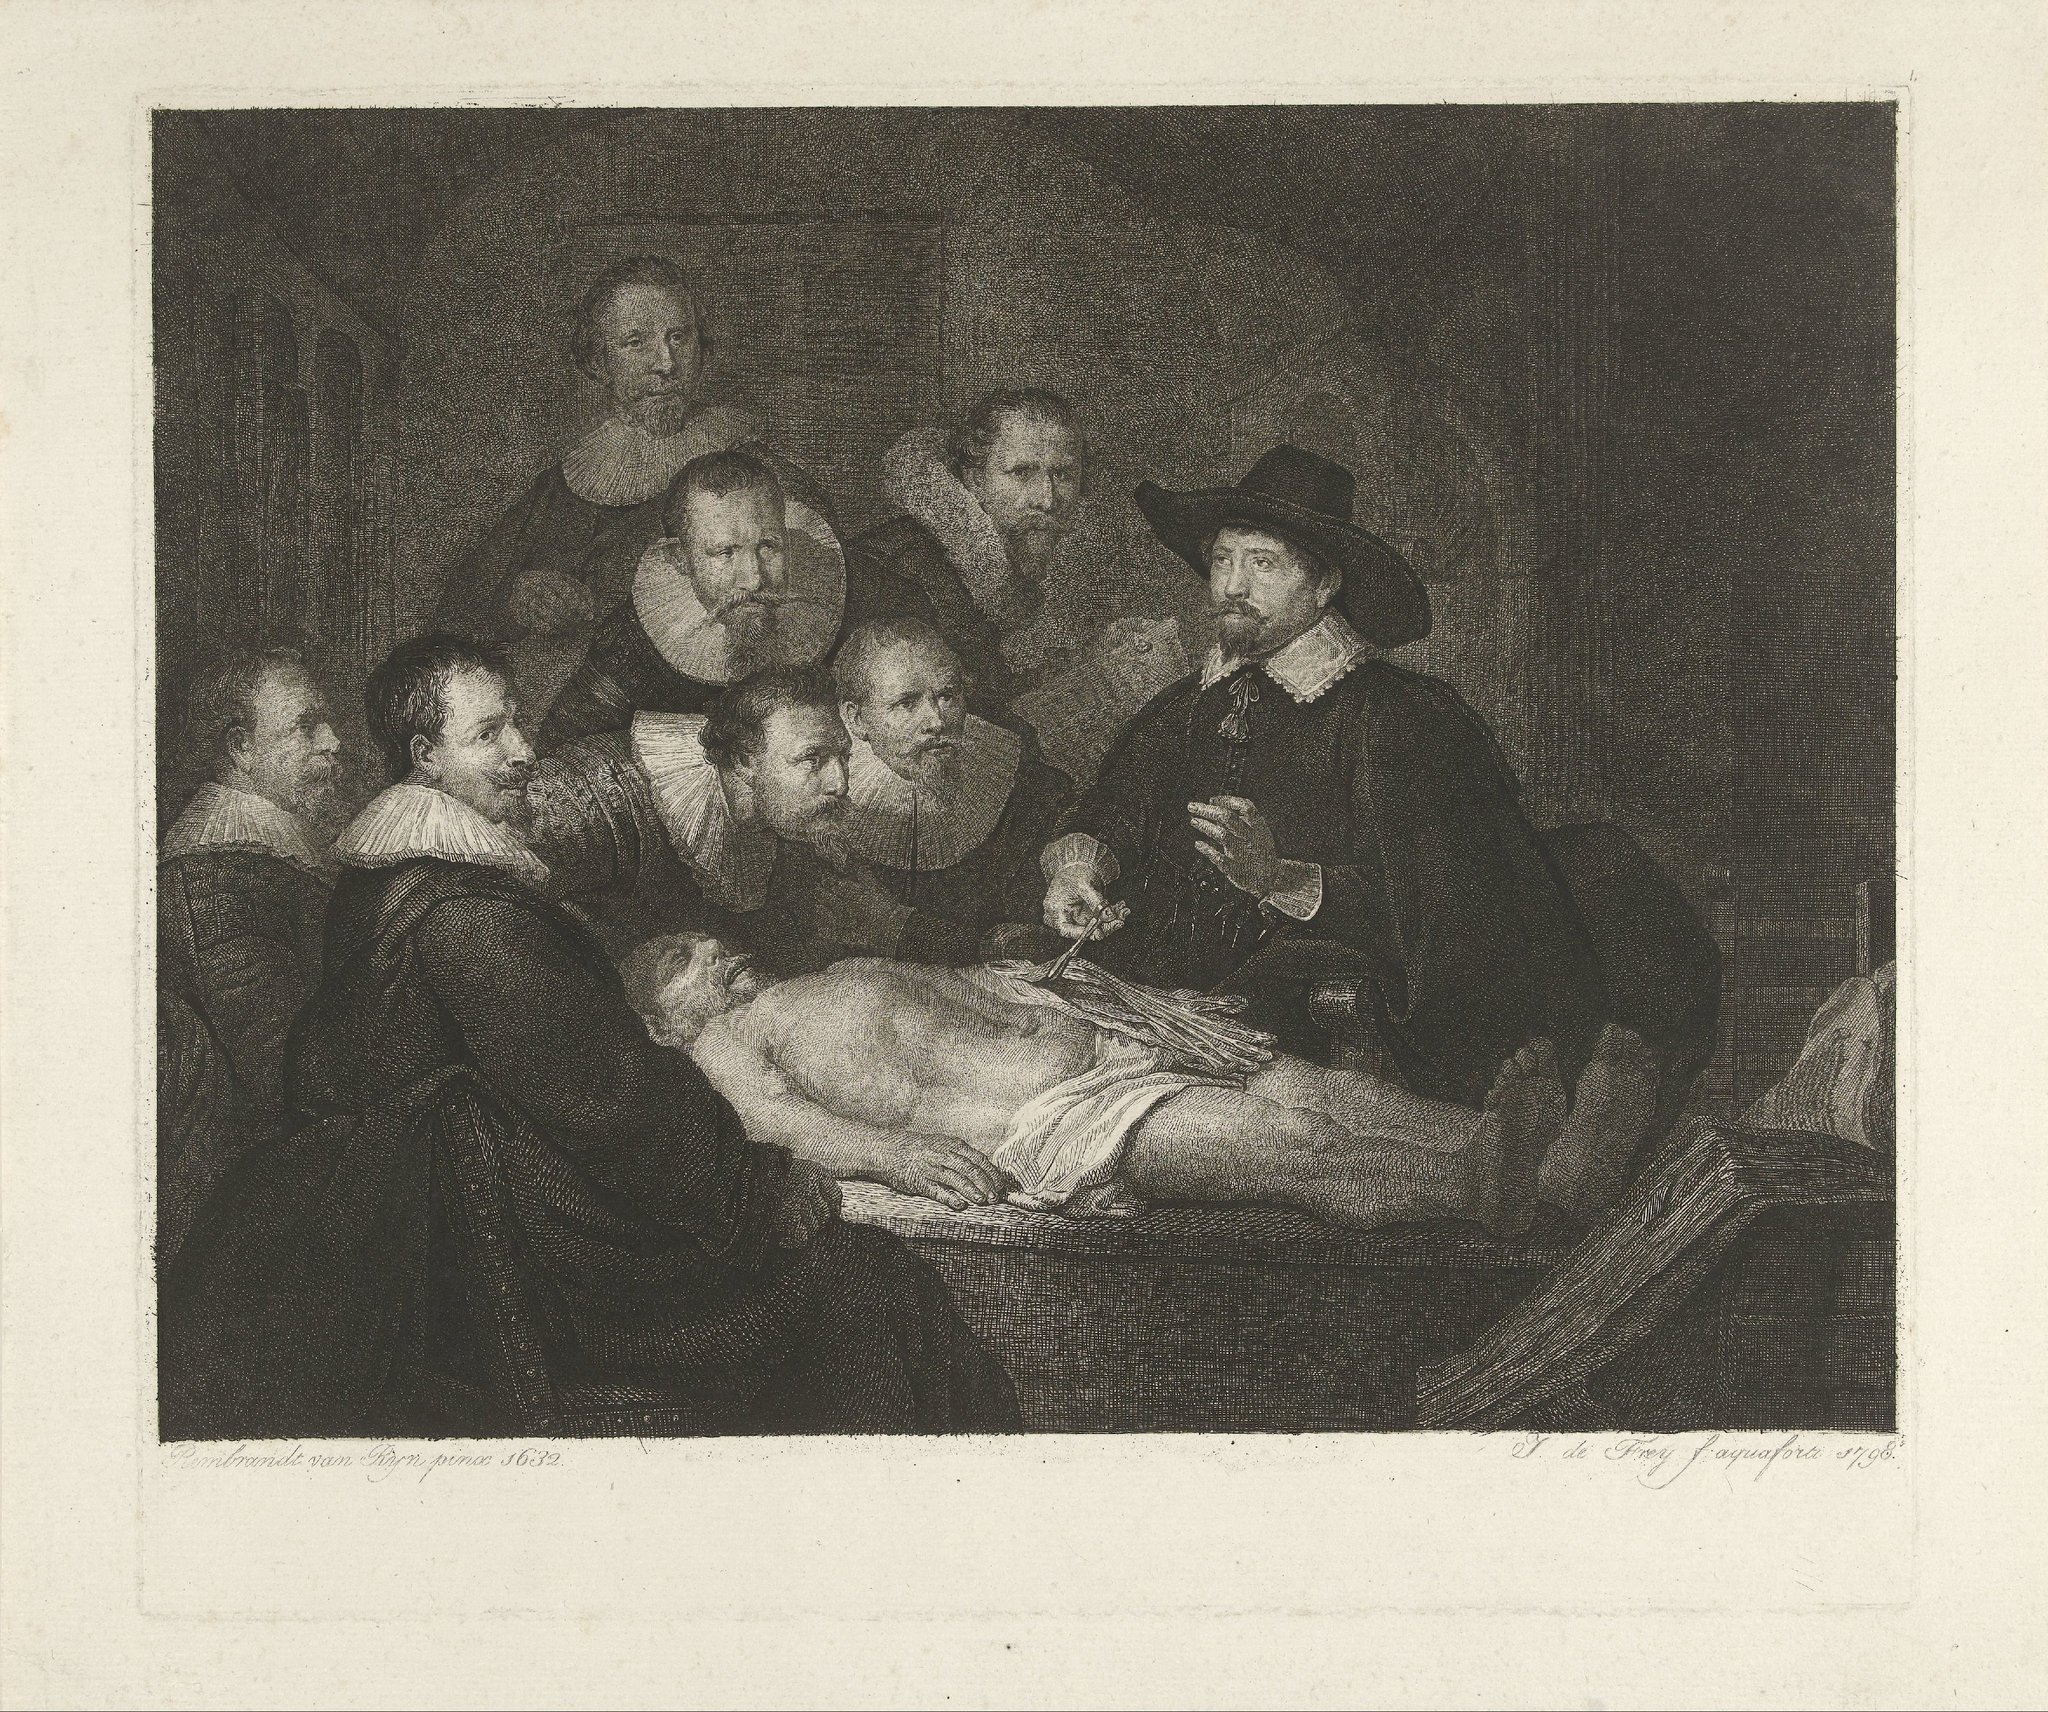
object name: print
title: Anatomische les van Dr. Nicolaes Tulp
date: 1798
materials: paper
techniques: etching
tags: amsterdam, the hague, mayor, historical persons, anatomy lesson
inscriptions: collector's mark: Lugt 12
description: Groepsportret van de Amsterdamse chirurgijns bij een anatomische les. De mannen zitten en staan rond een tafel waarop een lijk ligt. Dokter Nicolaes Tulp geeft onderricht. Hij heeft de arm van het lijk opengelegd en houdt met een tang een bundel armspieren omhoog, terwijl hij met zijn andere hand een demonstrerend gebaar maakt. Behalve Nicolaes Tulp, staan ook de chirurgen Jacob Blok, Hartman Hartmansz., Adraen Slabran, Jacob de Witt, Mathijs Kalkoen, Jacob Koolvelt en Frans van Loenen afgebeeld.